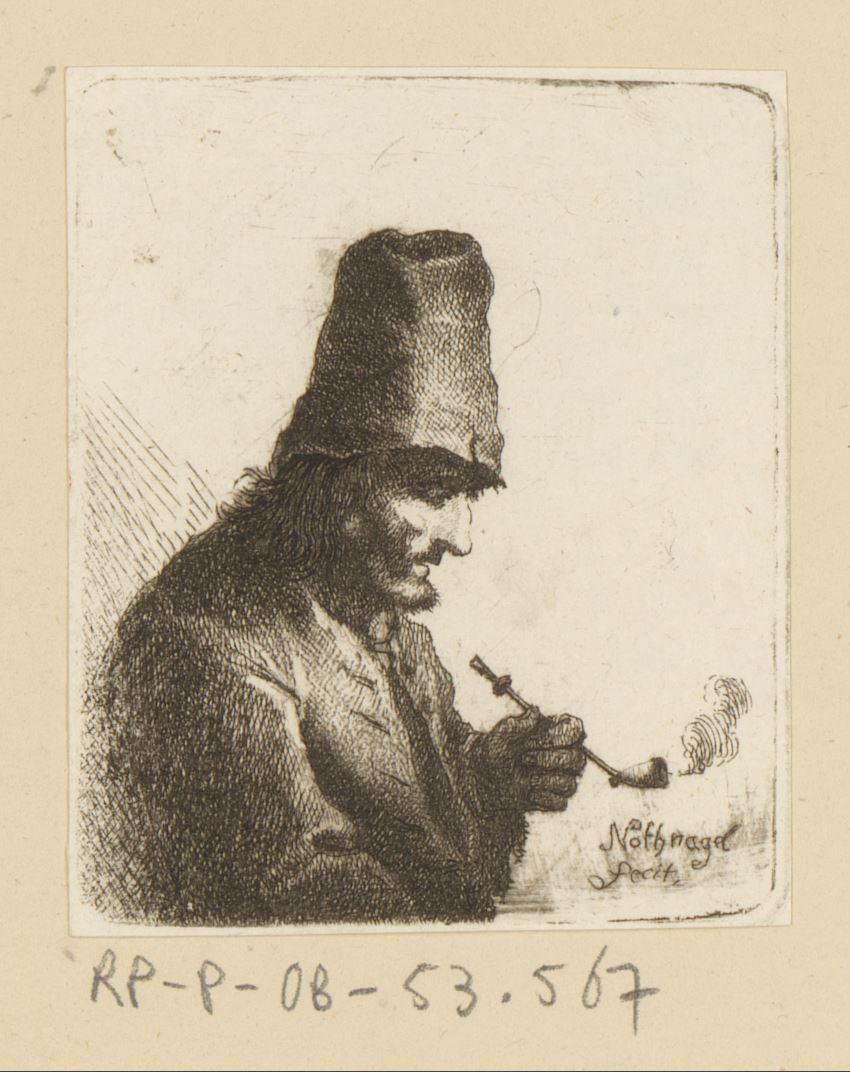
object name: print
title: Man met pijp en hoge muts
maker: johann andreas benjamin nothnagel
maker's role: print maker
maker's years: 1729-1804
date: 1739-1804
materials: paper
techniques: etching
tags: head-gear: cap (+ men's clothes), pipe ~ tobacco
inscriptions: collector's mark: Lugt 240